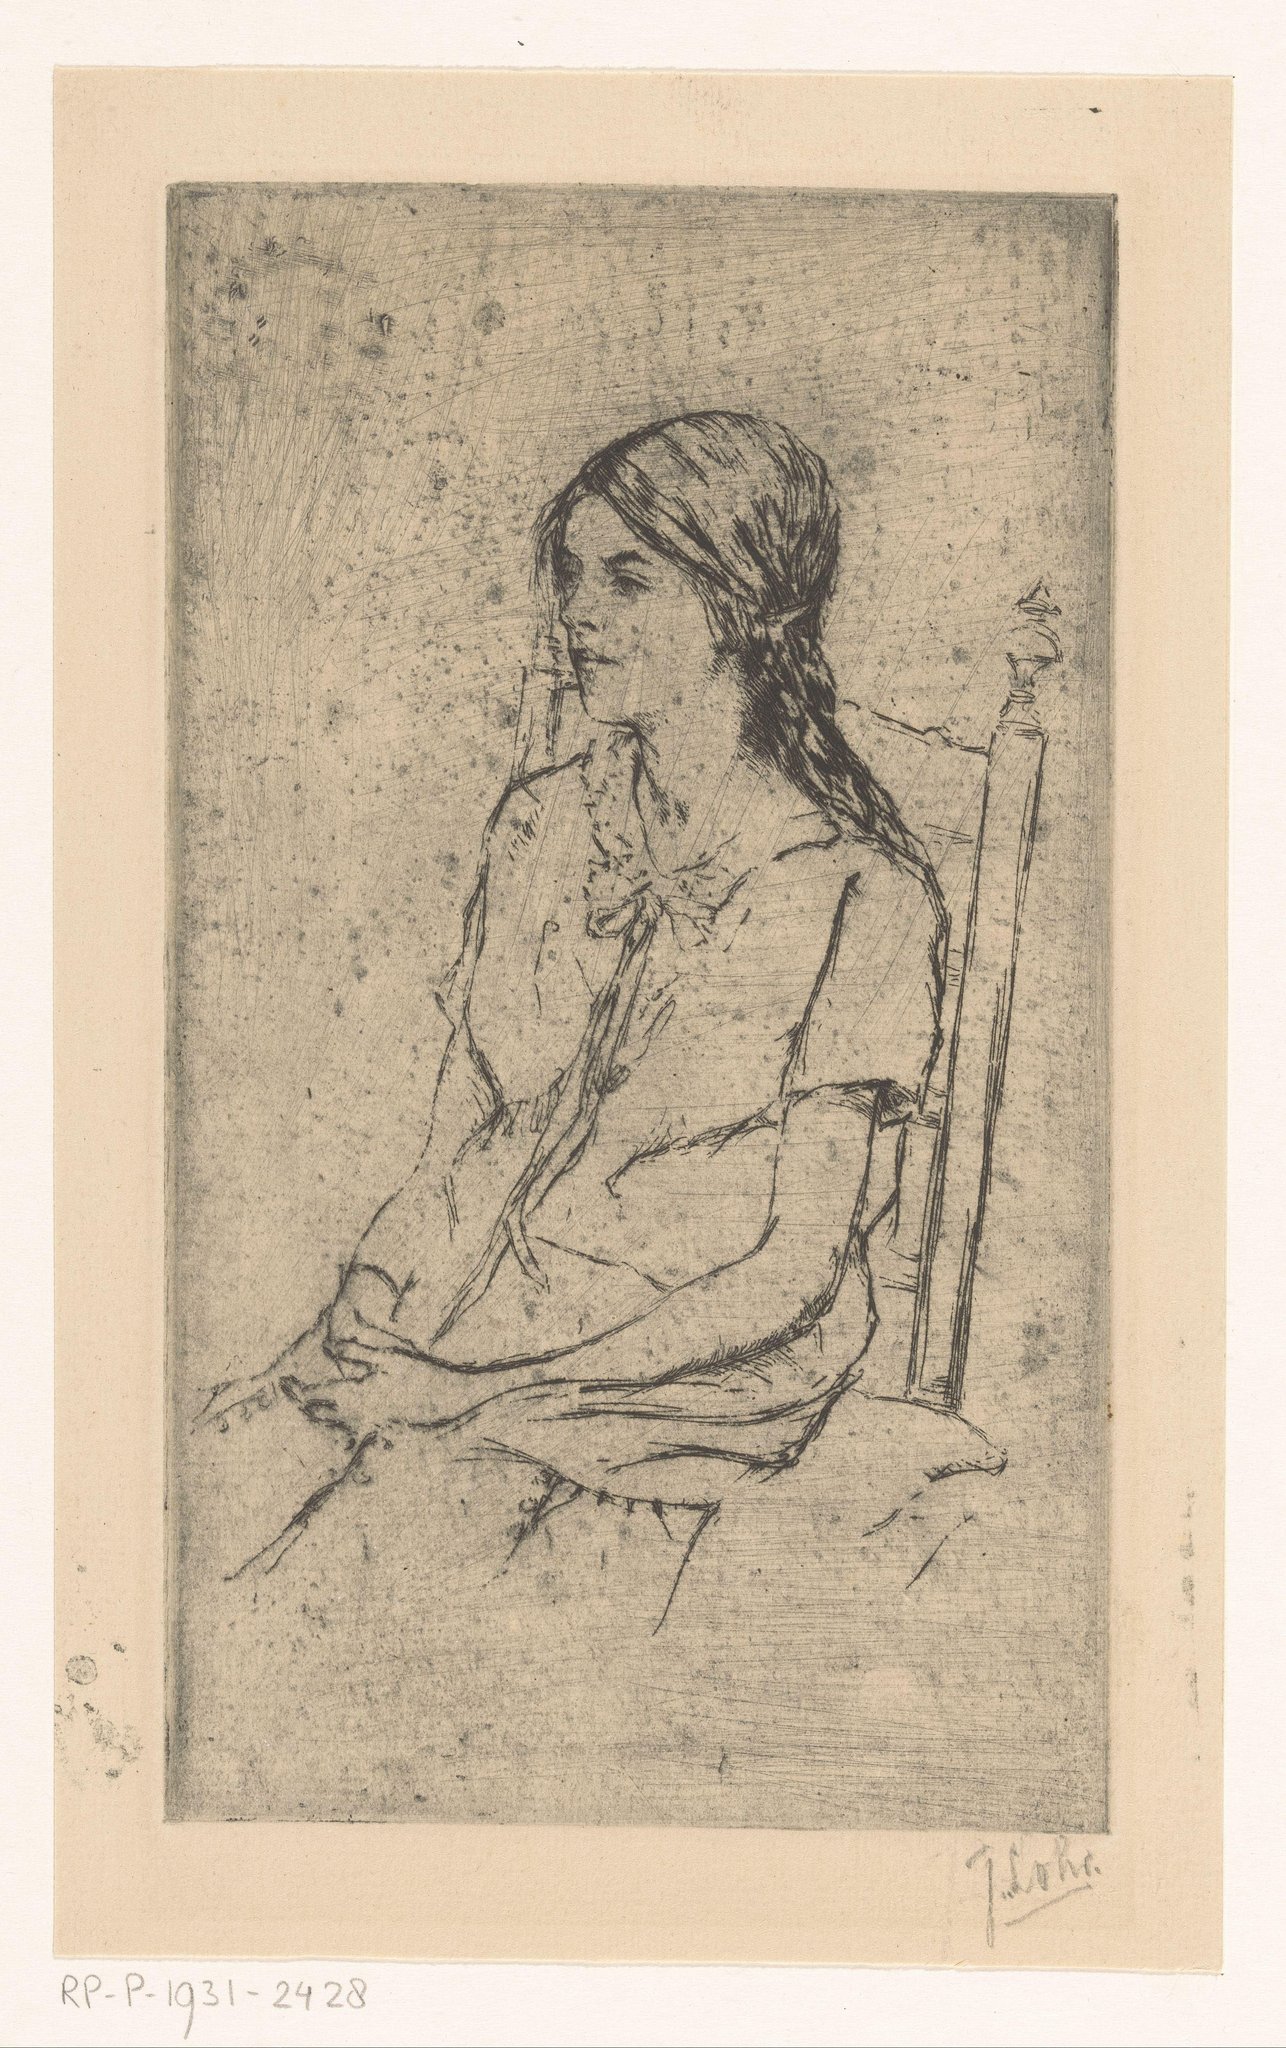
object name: print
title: Meisje op stoel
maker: johannes löhr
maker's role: print maker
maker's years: 1882-1928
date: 1892-1928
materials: paper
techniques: etching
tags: adolescent, young woman, maiden, sitting figure - aa - female human figure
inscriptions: collector's mark: Lugt 2228